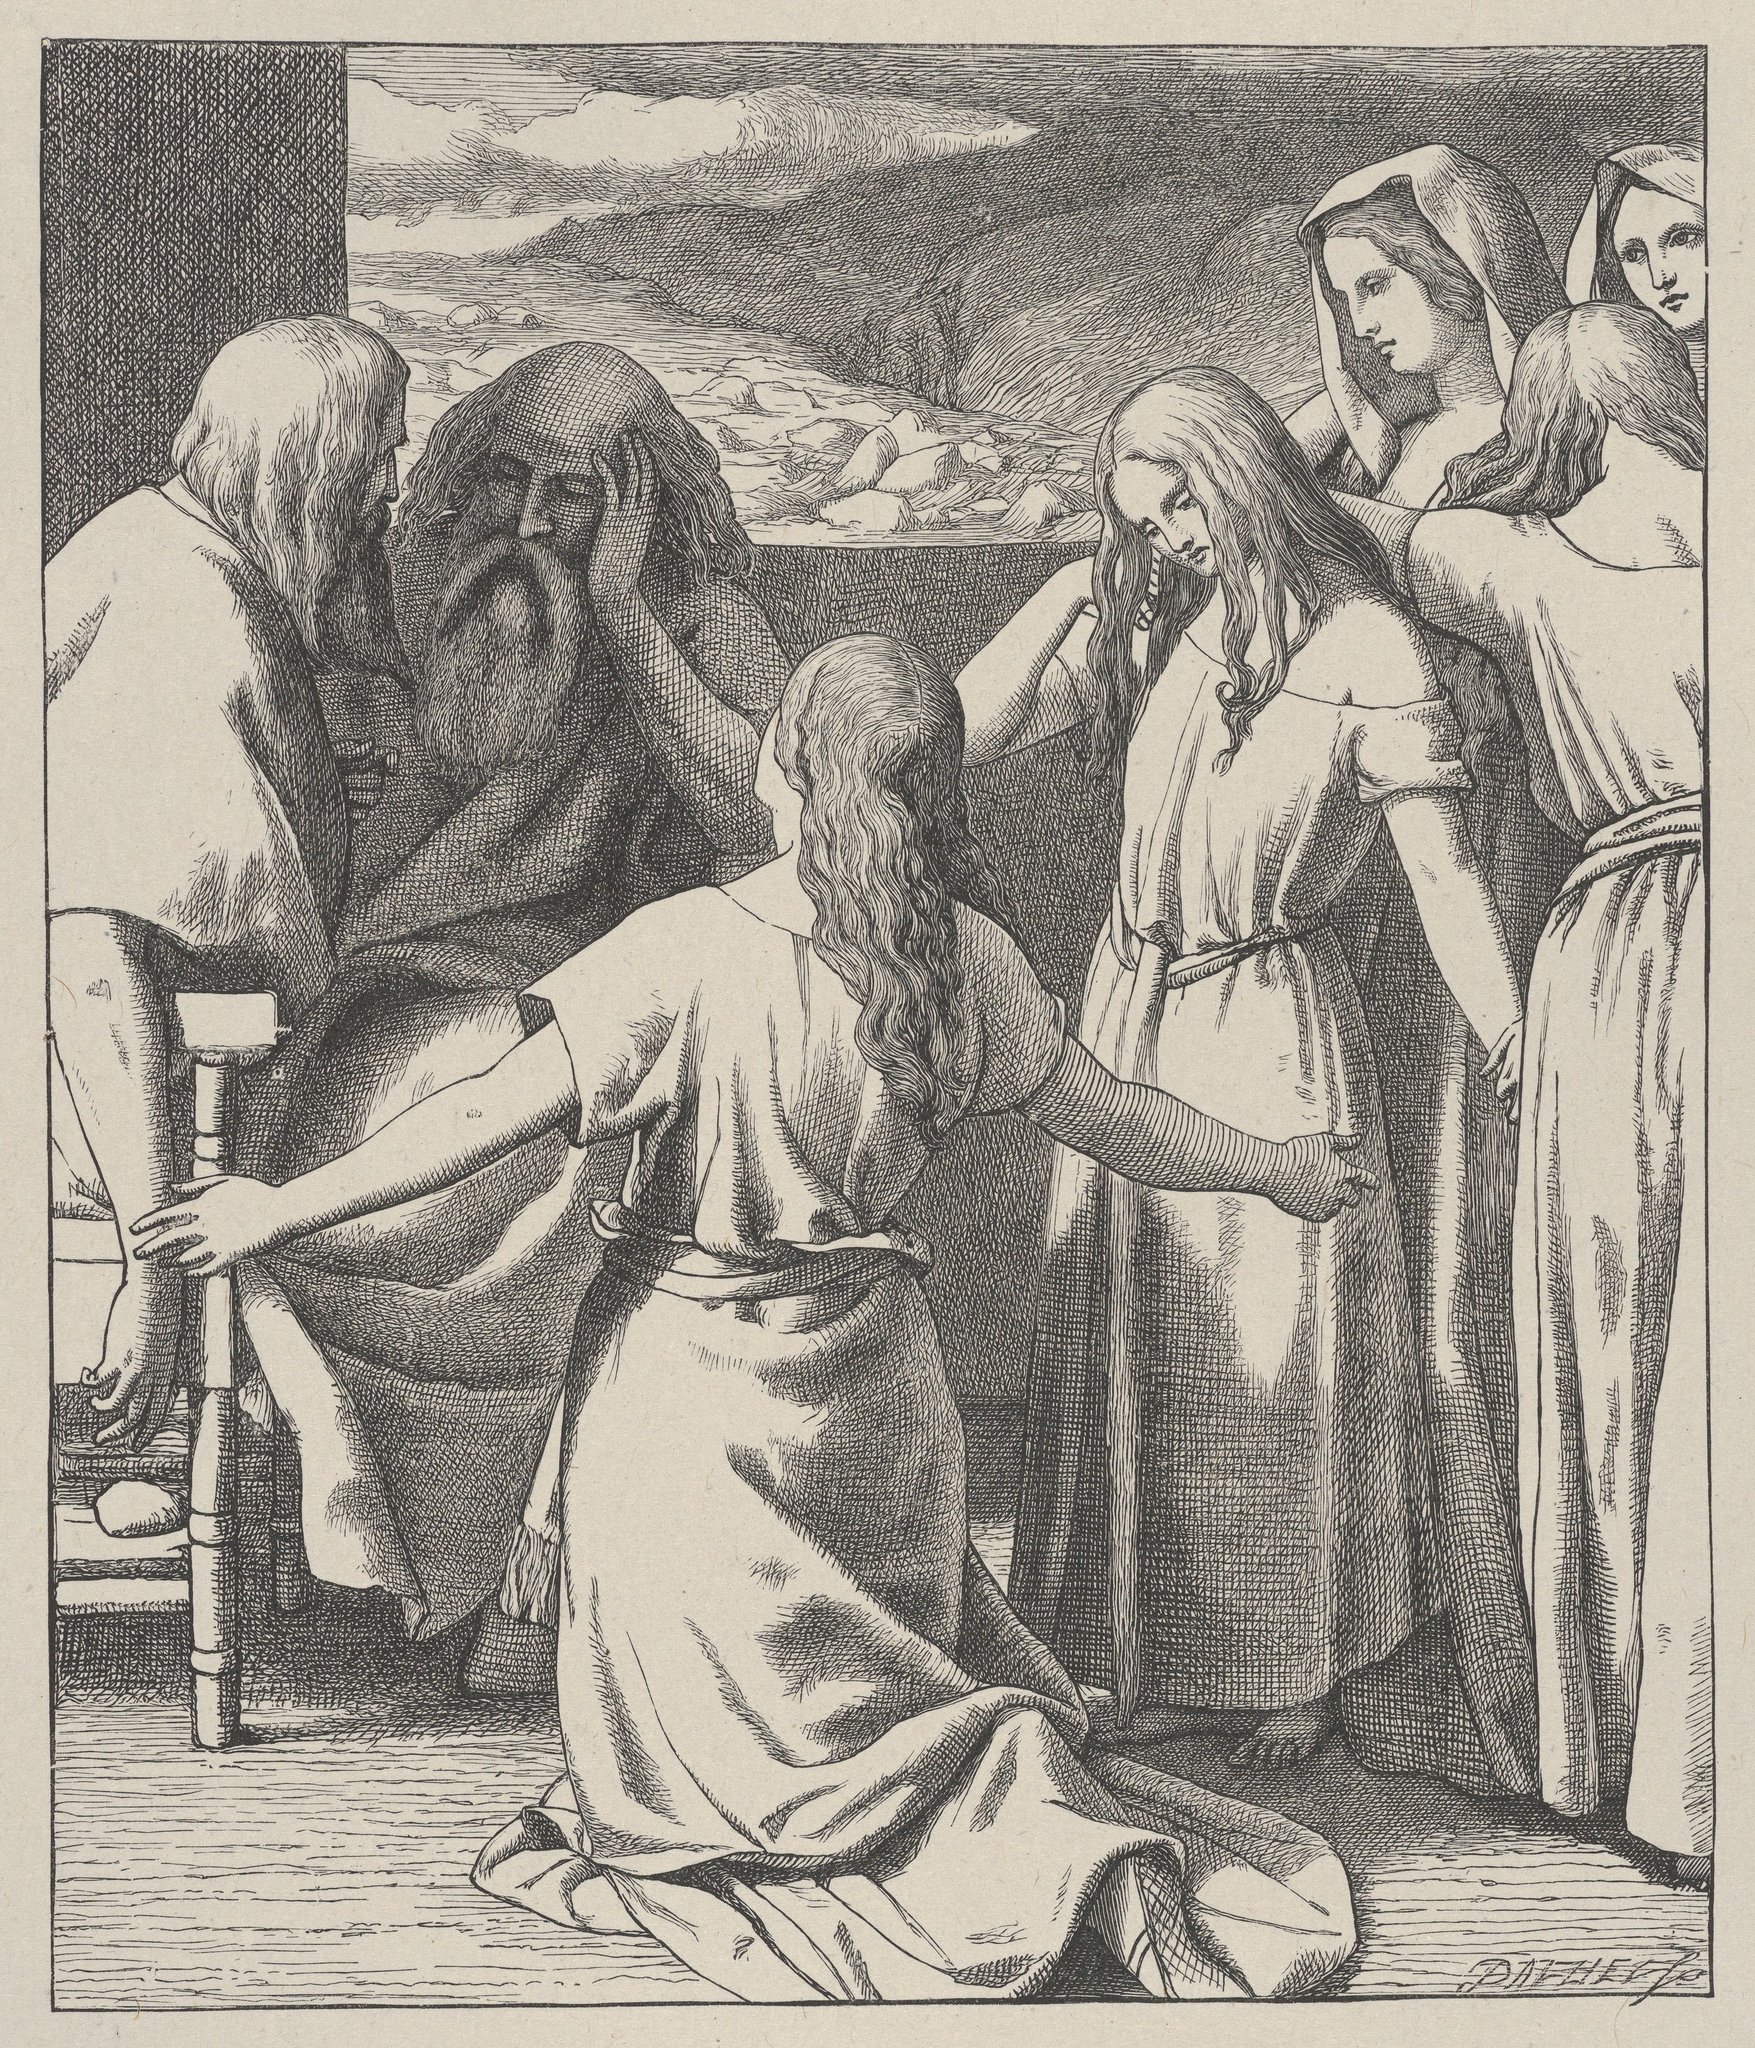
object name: print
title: The Daughters of Zelophehad, from "Dalziels' Bible Gallery"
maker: frederick richard pickersgill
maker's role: artist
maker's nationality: british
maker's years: 1820-1900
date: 1865-1881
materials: paper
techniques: engraving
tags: men,women